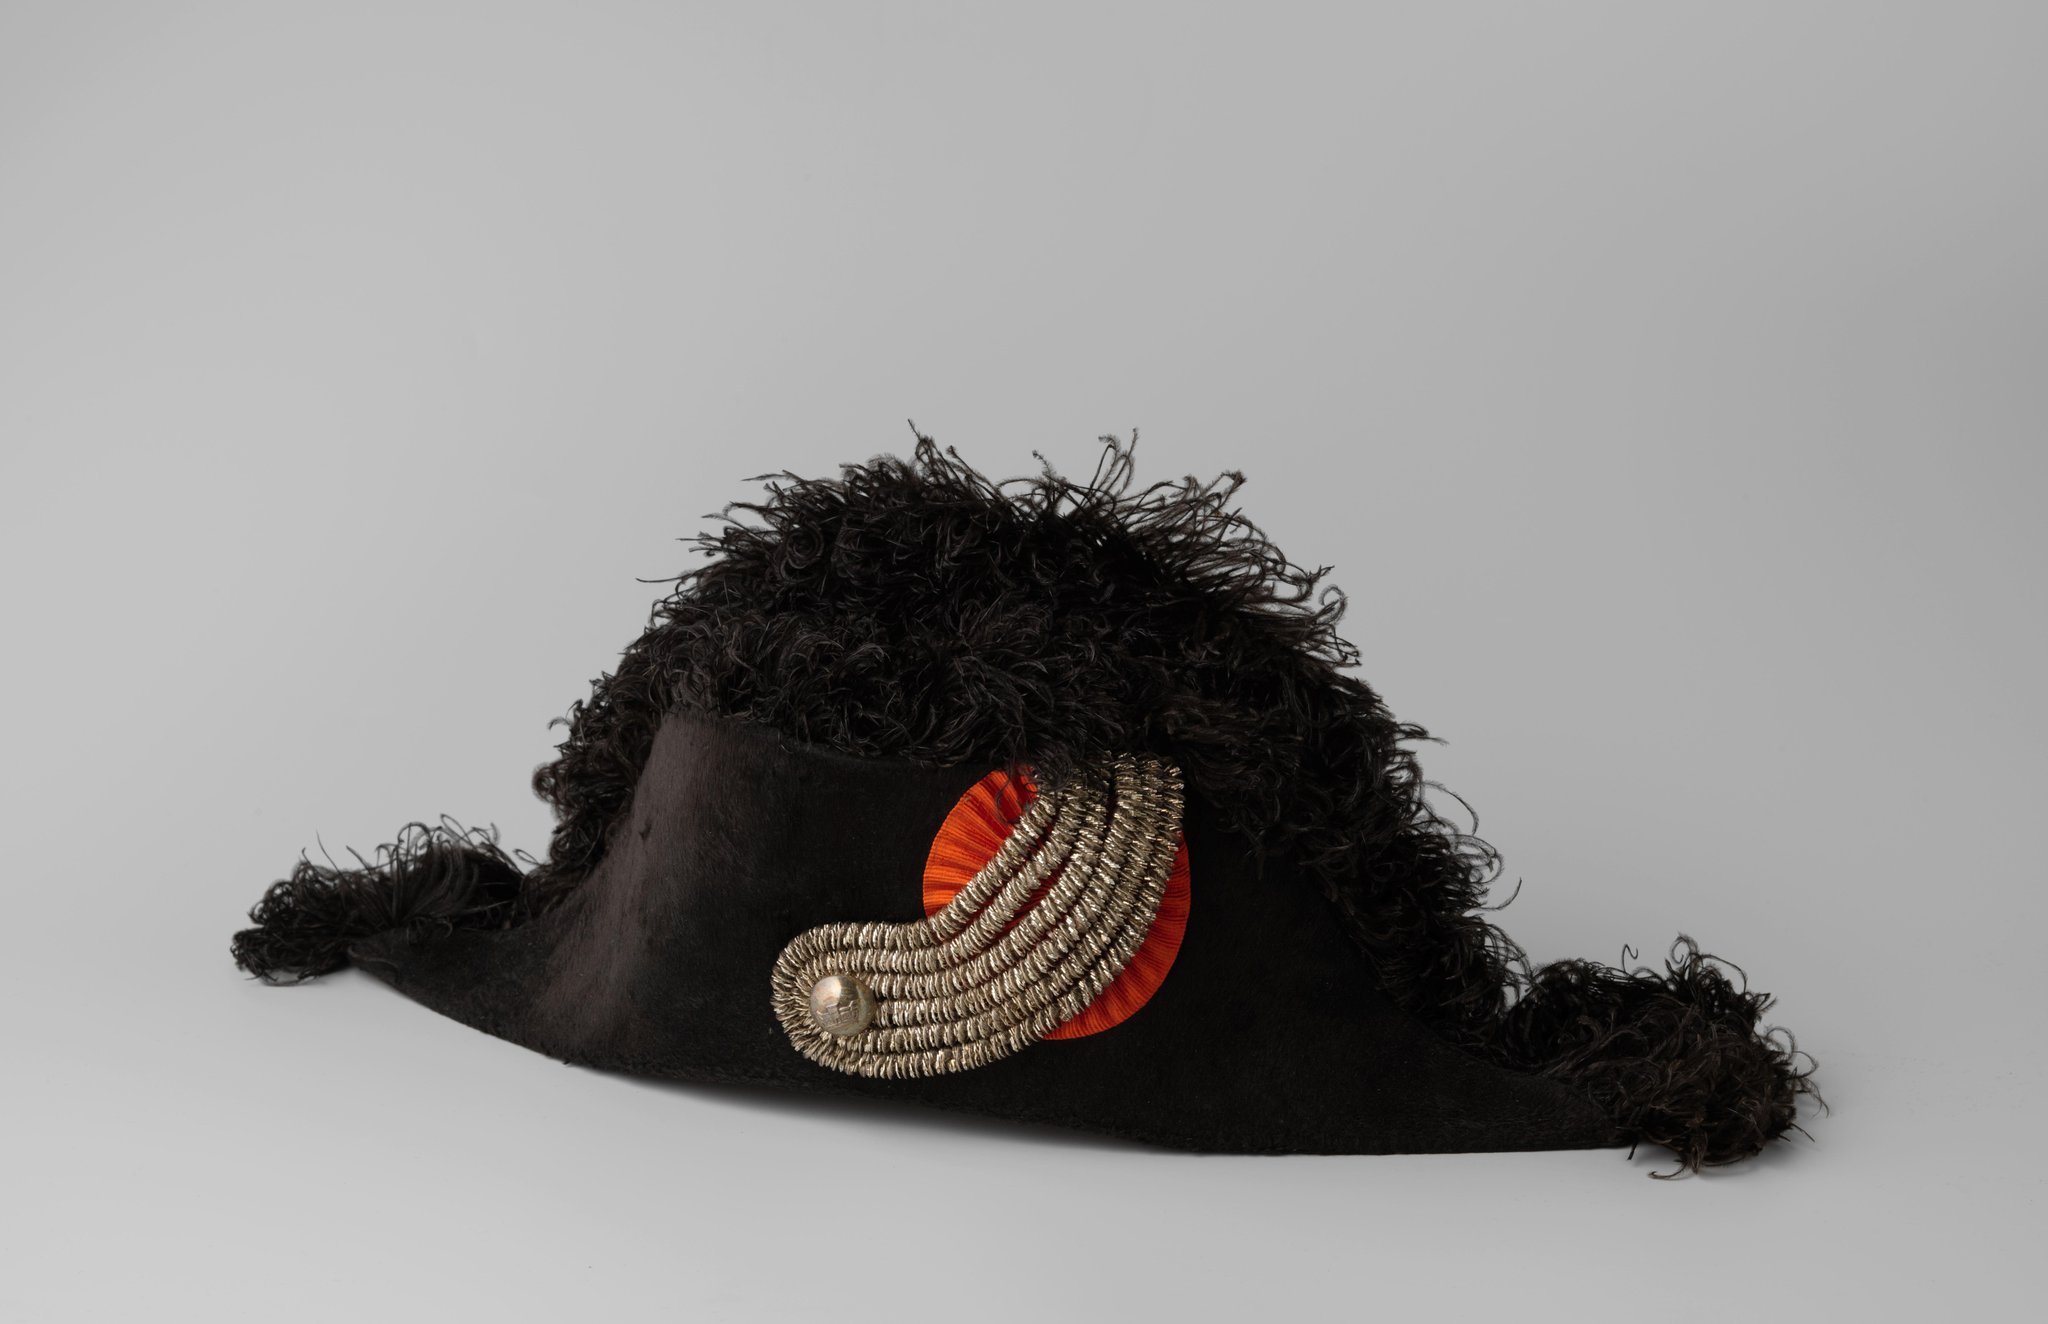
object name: bicorne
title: Steek heeft toebehoord aan H.M.A.J. van Asch van Wijck, burgemeester van Utrecht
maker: isaäc johannes froger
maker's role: hoedenmaker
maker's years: 1781-1843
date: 1827-1839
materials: felt, textile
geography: amsterdam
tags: politician, utrecht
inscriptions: mark: ‘L.J. Froger et Fils à Amsterdam’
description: Steek, afgezet met kort zwart struisveer; aan de rechterzijde lis van zilverkoord en oranje kokarde. Deze steek heeft toebehoord aan H.M.A.J. van Asch van Wijck, burgemeester van Utrecht (1827-1839). Bij de steek zit een blikken trommel waarin hij kan worden opgeborgen. De steek is gemerkt.